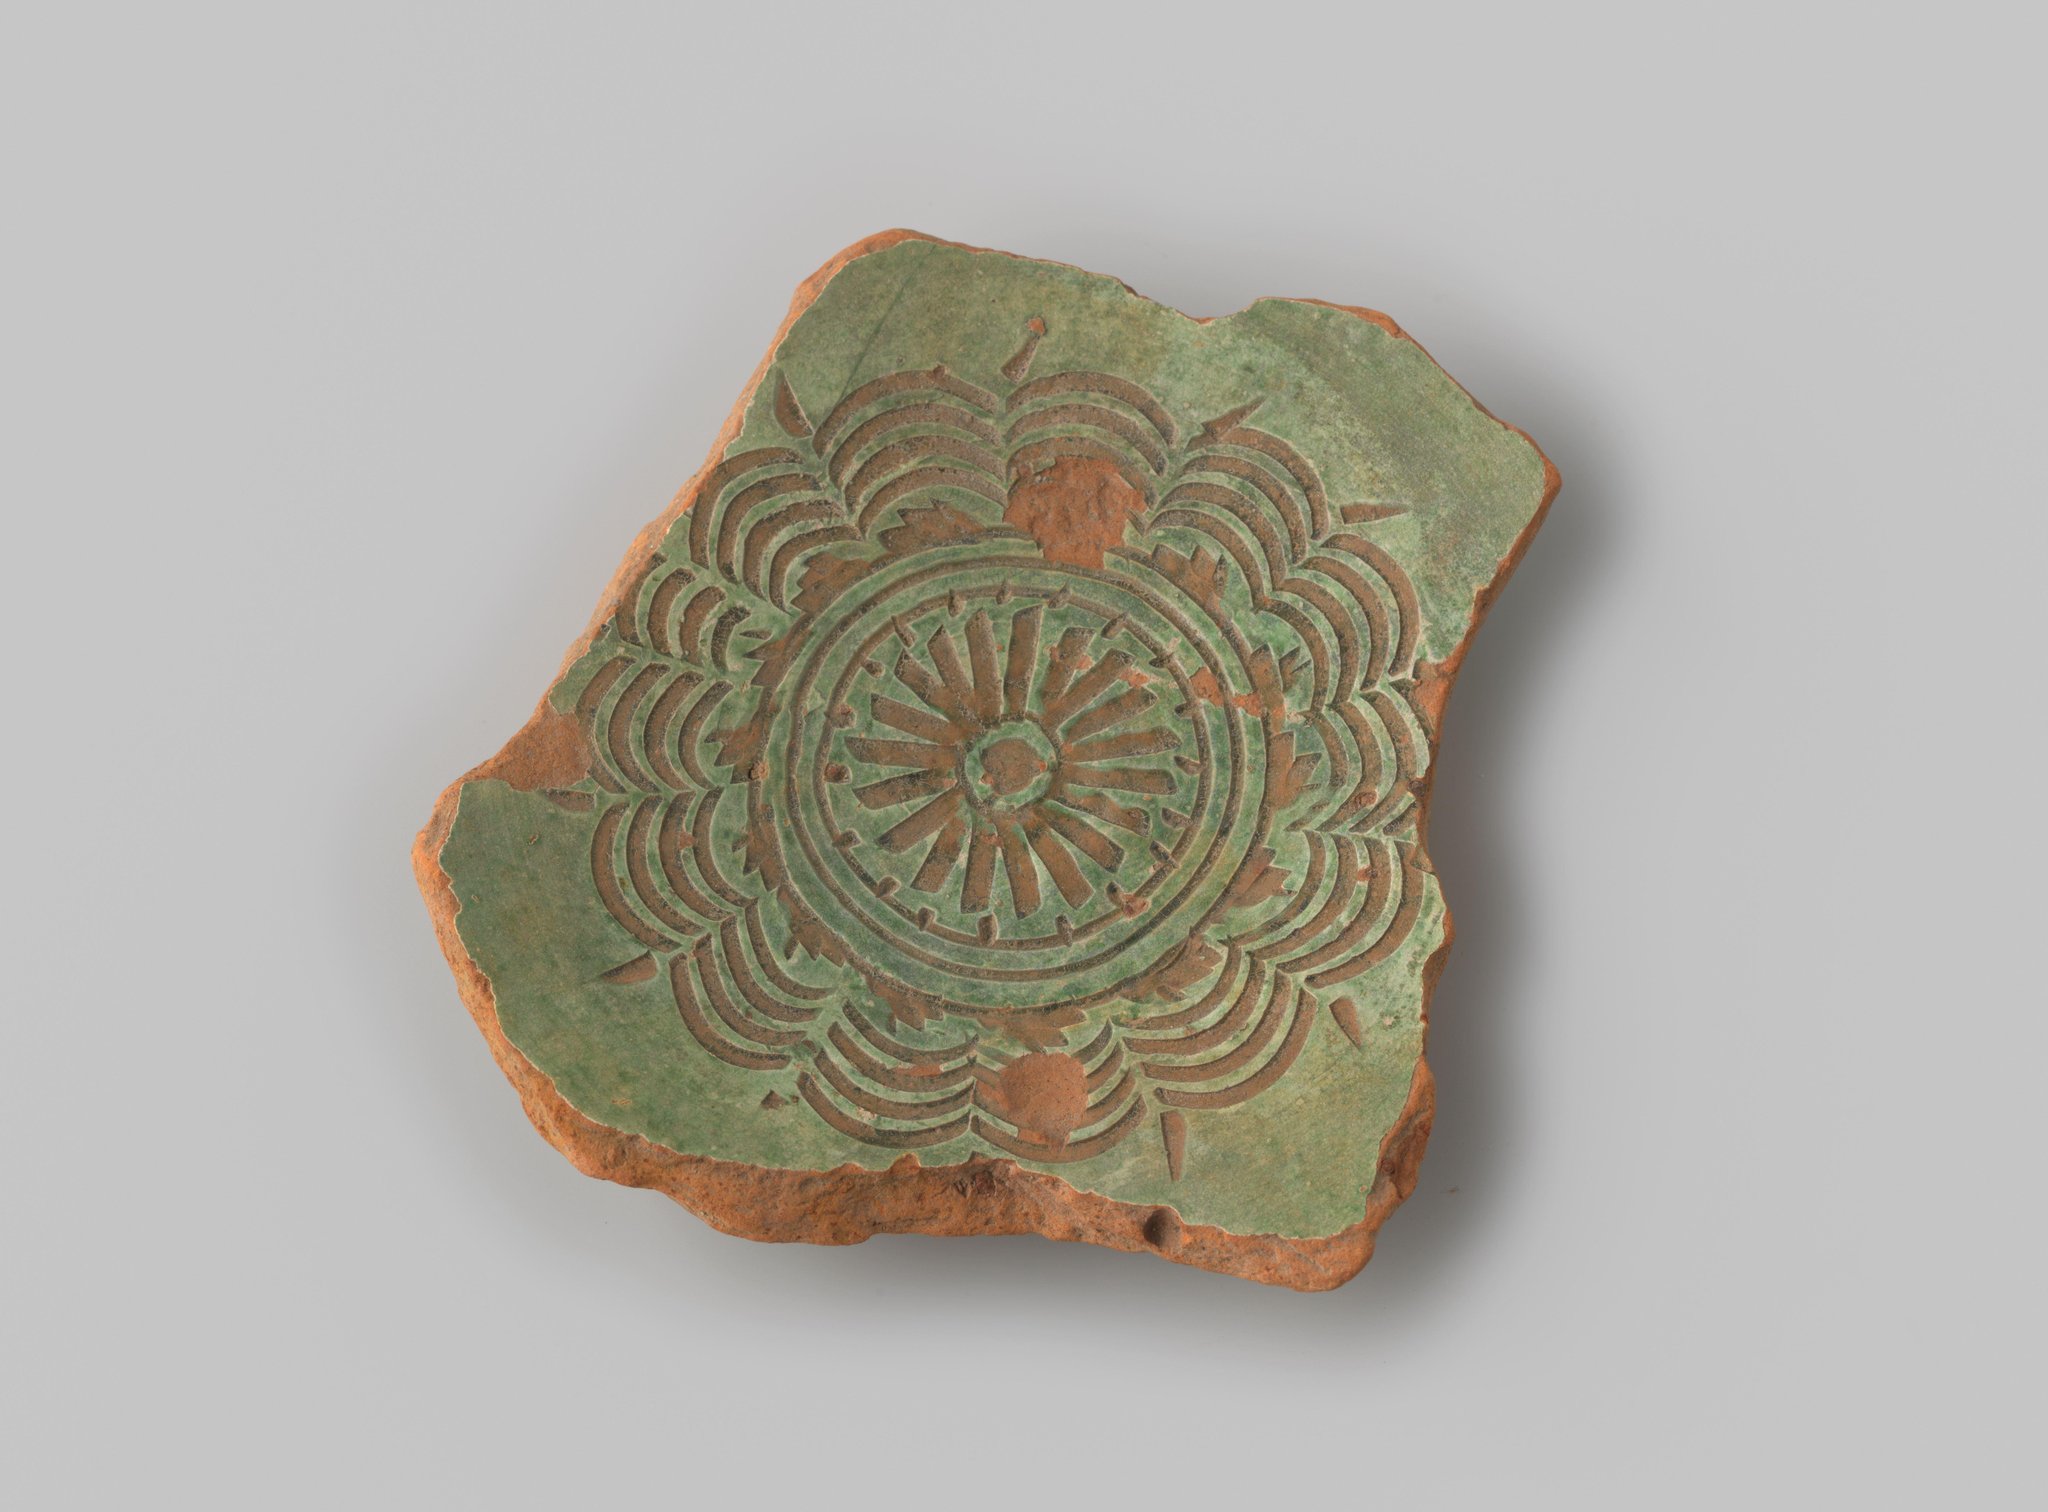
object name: sherd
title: Fragment met rode scherf, aan de bovenzijde voorzien van een bloem in sgrafitto-techniek in groen glazuur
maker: Anonymous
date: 1200-1899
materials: earthenware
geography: italy